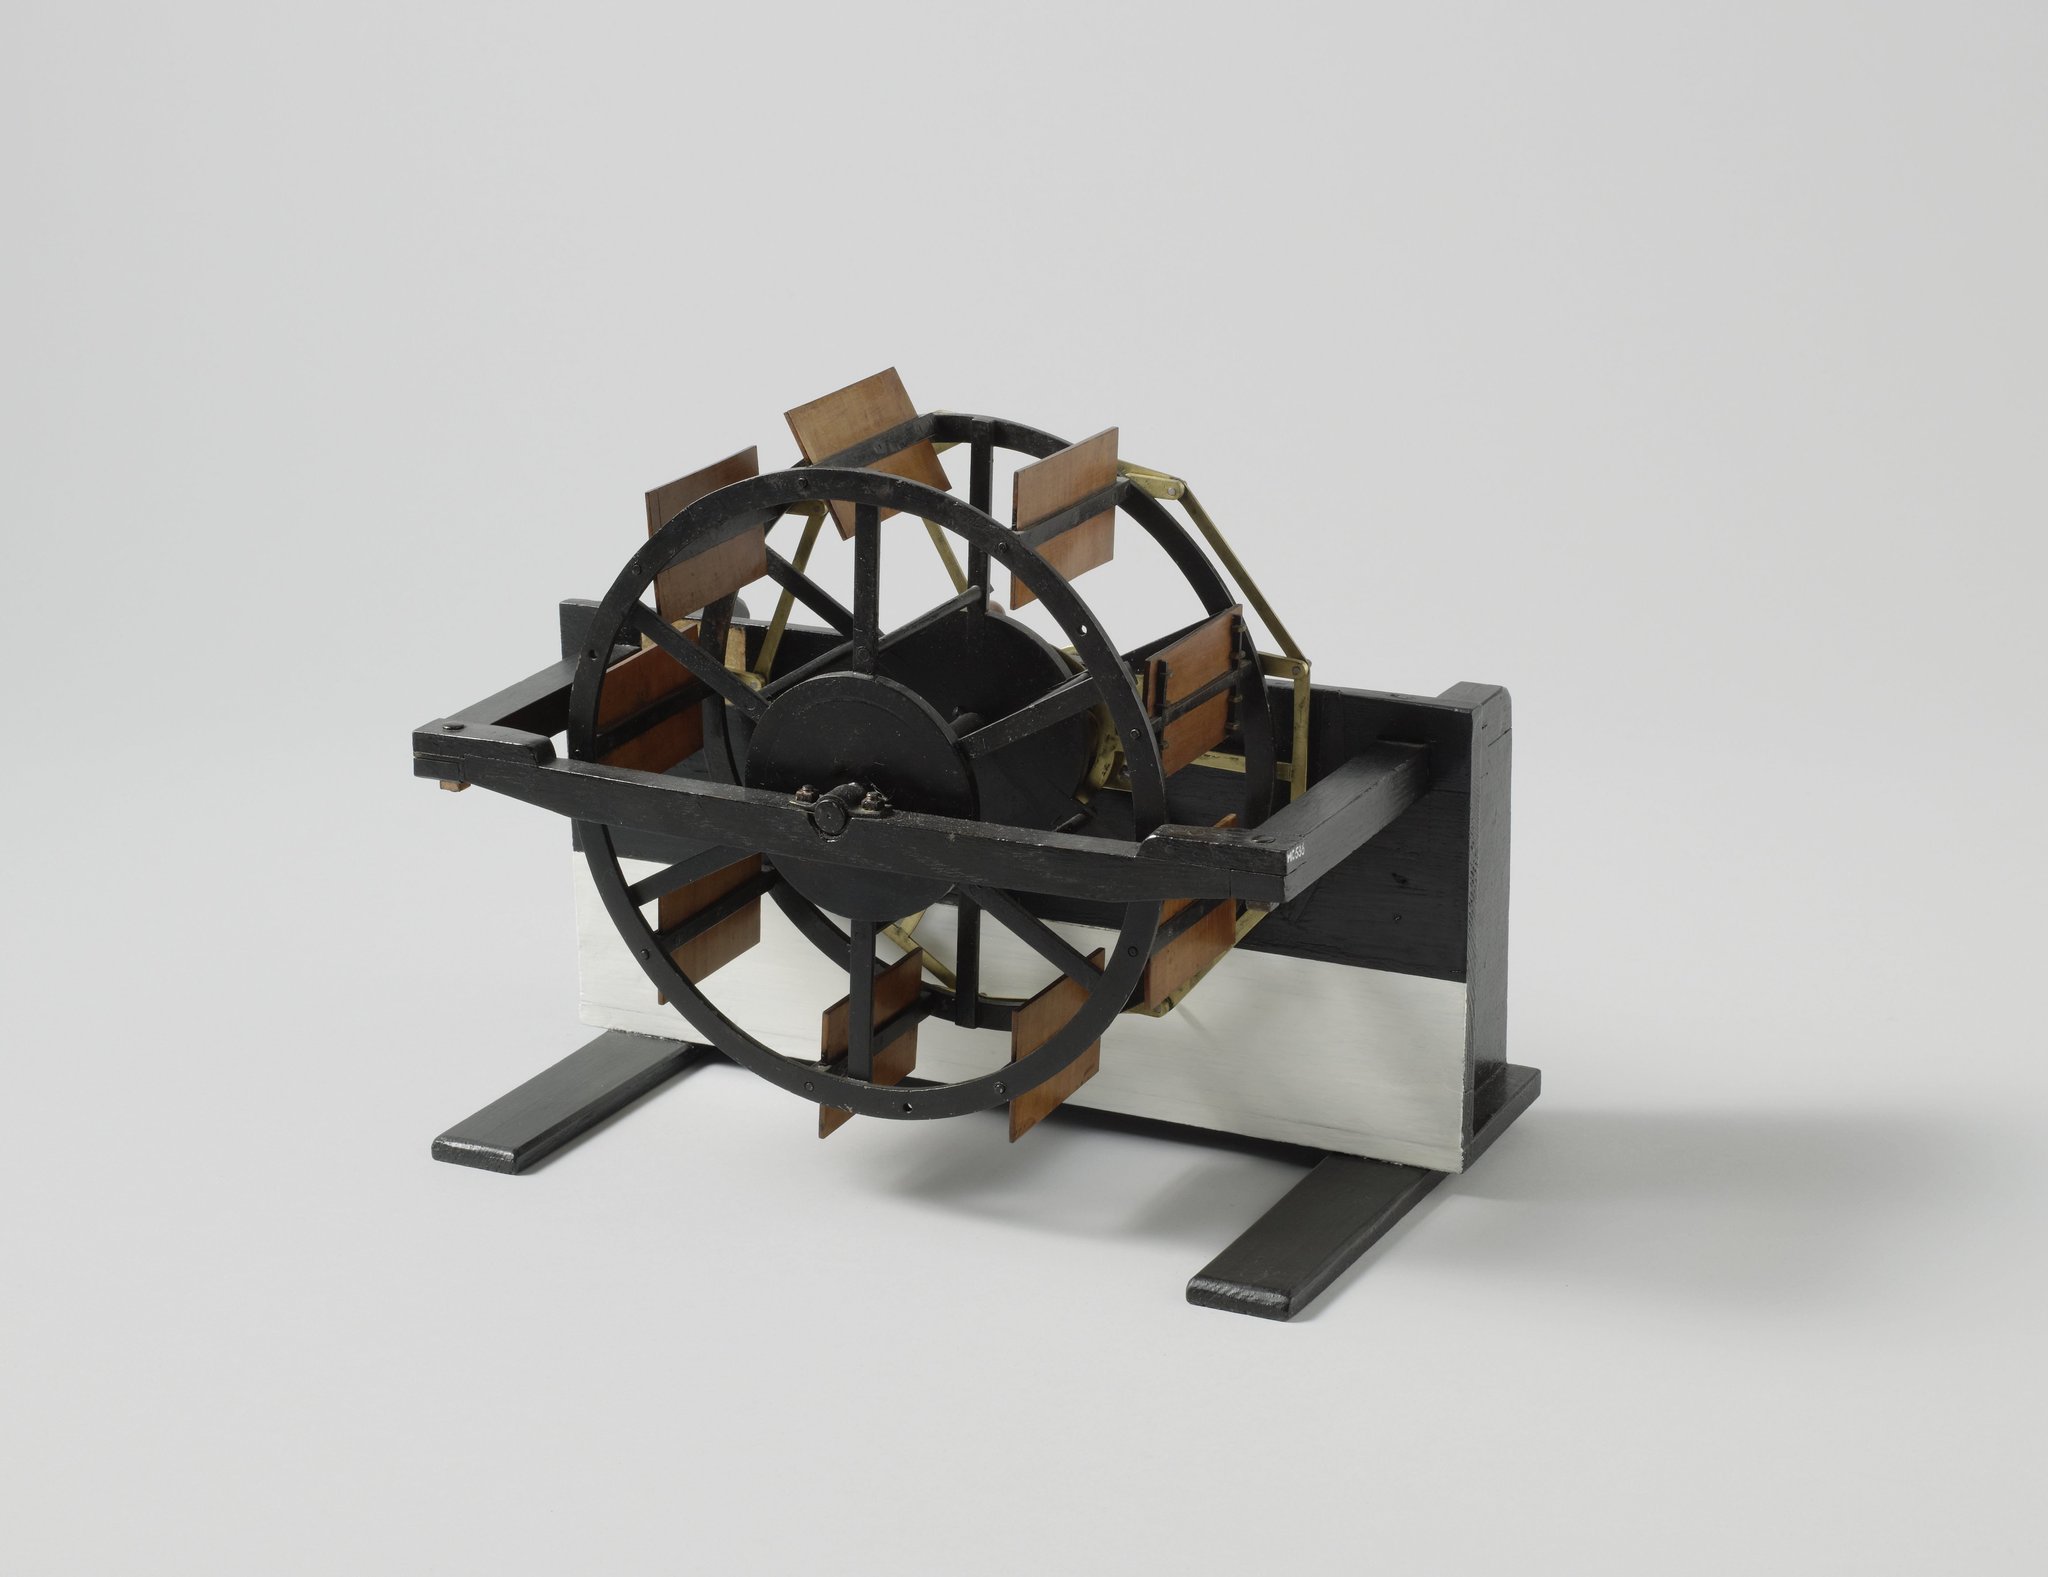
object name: demonstration model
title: Model of a Paddle Wheel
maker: Anonymous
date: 1834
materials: brass, iron, wood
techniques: polychromy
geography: netherlands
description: Dit model werd in 1834 ontworpen en gemaakt door Francois Wathier, machinist van het stoomschip Suriname, naar de schepraderen van het Franse stoomschip Estaphette, varend tussen Rotterdam en Duinkerken. Het doel van het ontwerp was het verkrijgen van een vertikale stand van de borden op het moment dat zij het water ingaan en weer uitkomen, wat de trilling van de raderwielen sterk verminderde. Ondanks de aanbeveling van SBN A.C. Twent werd Wathiers ontwerp te licht bevonden en werd gekozen voor de Franse en Engelse ontwerpen (NG-MC-538 & 539). Precies hetzelfde principe in een iets andere uitvoering is te zien op een prototype model van een raderstoomboot uit 1784 van de Fransman Le Comte De Jouffroy D'abbans in het Musée de la Marine in Parijs.